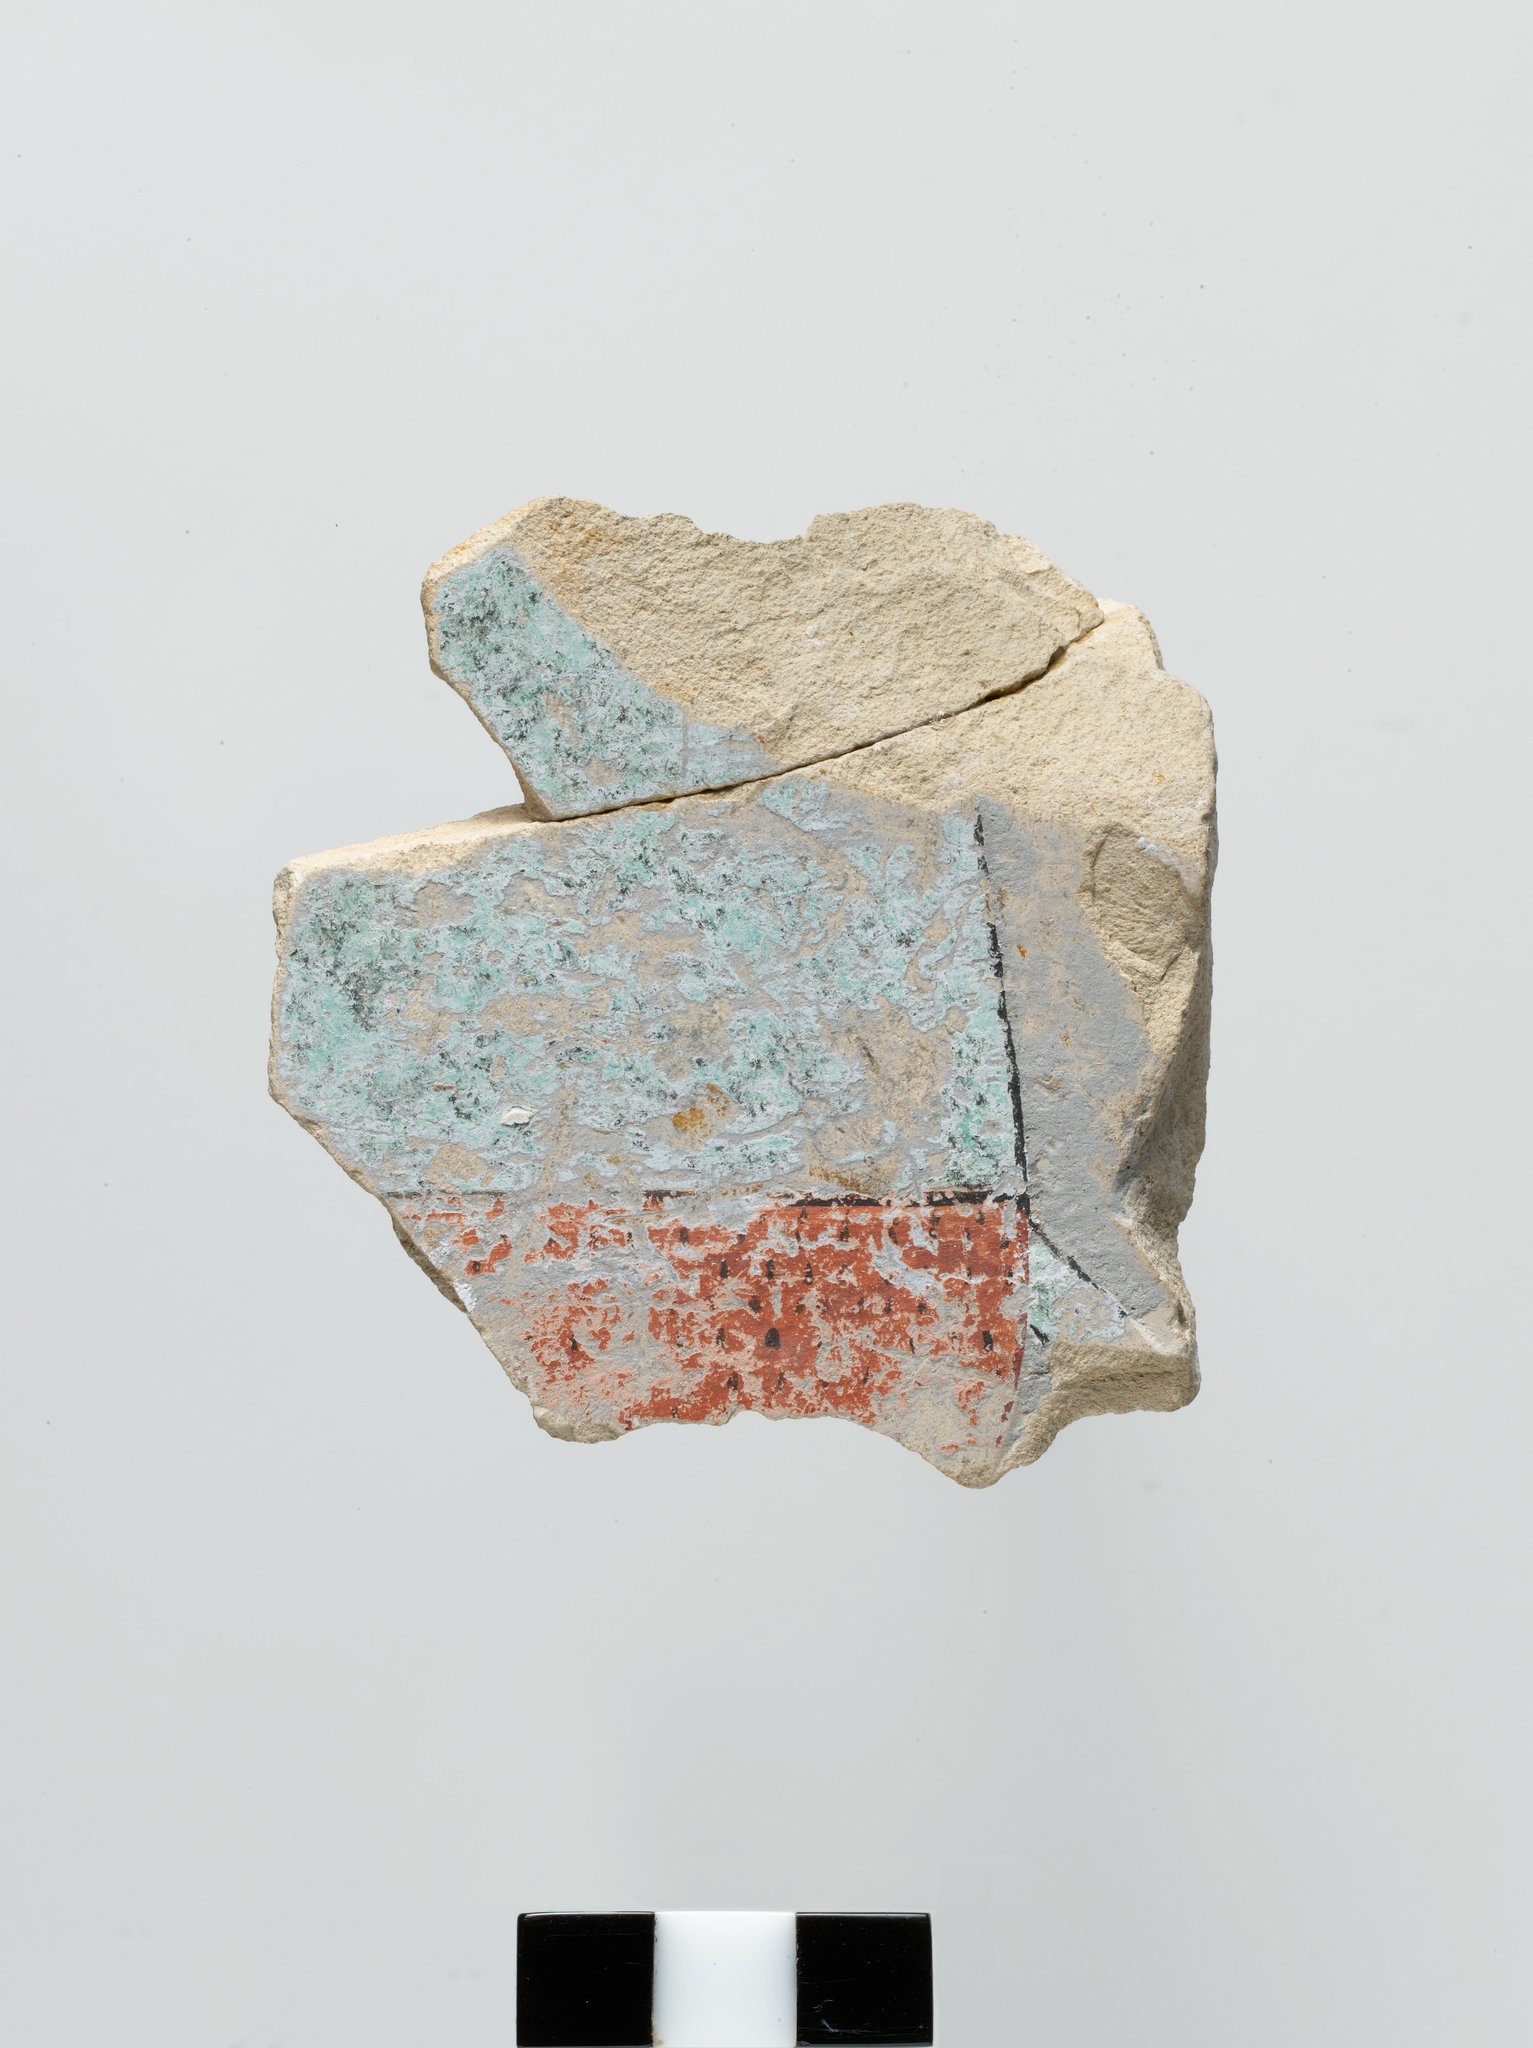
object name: relief fragment, tomb of meketre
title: Relief fragments from tomb of Meketre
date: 1981-1975 BCE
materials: limestone, paint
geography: egypt